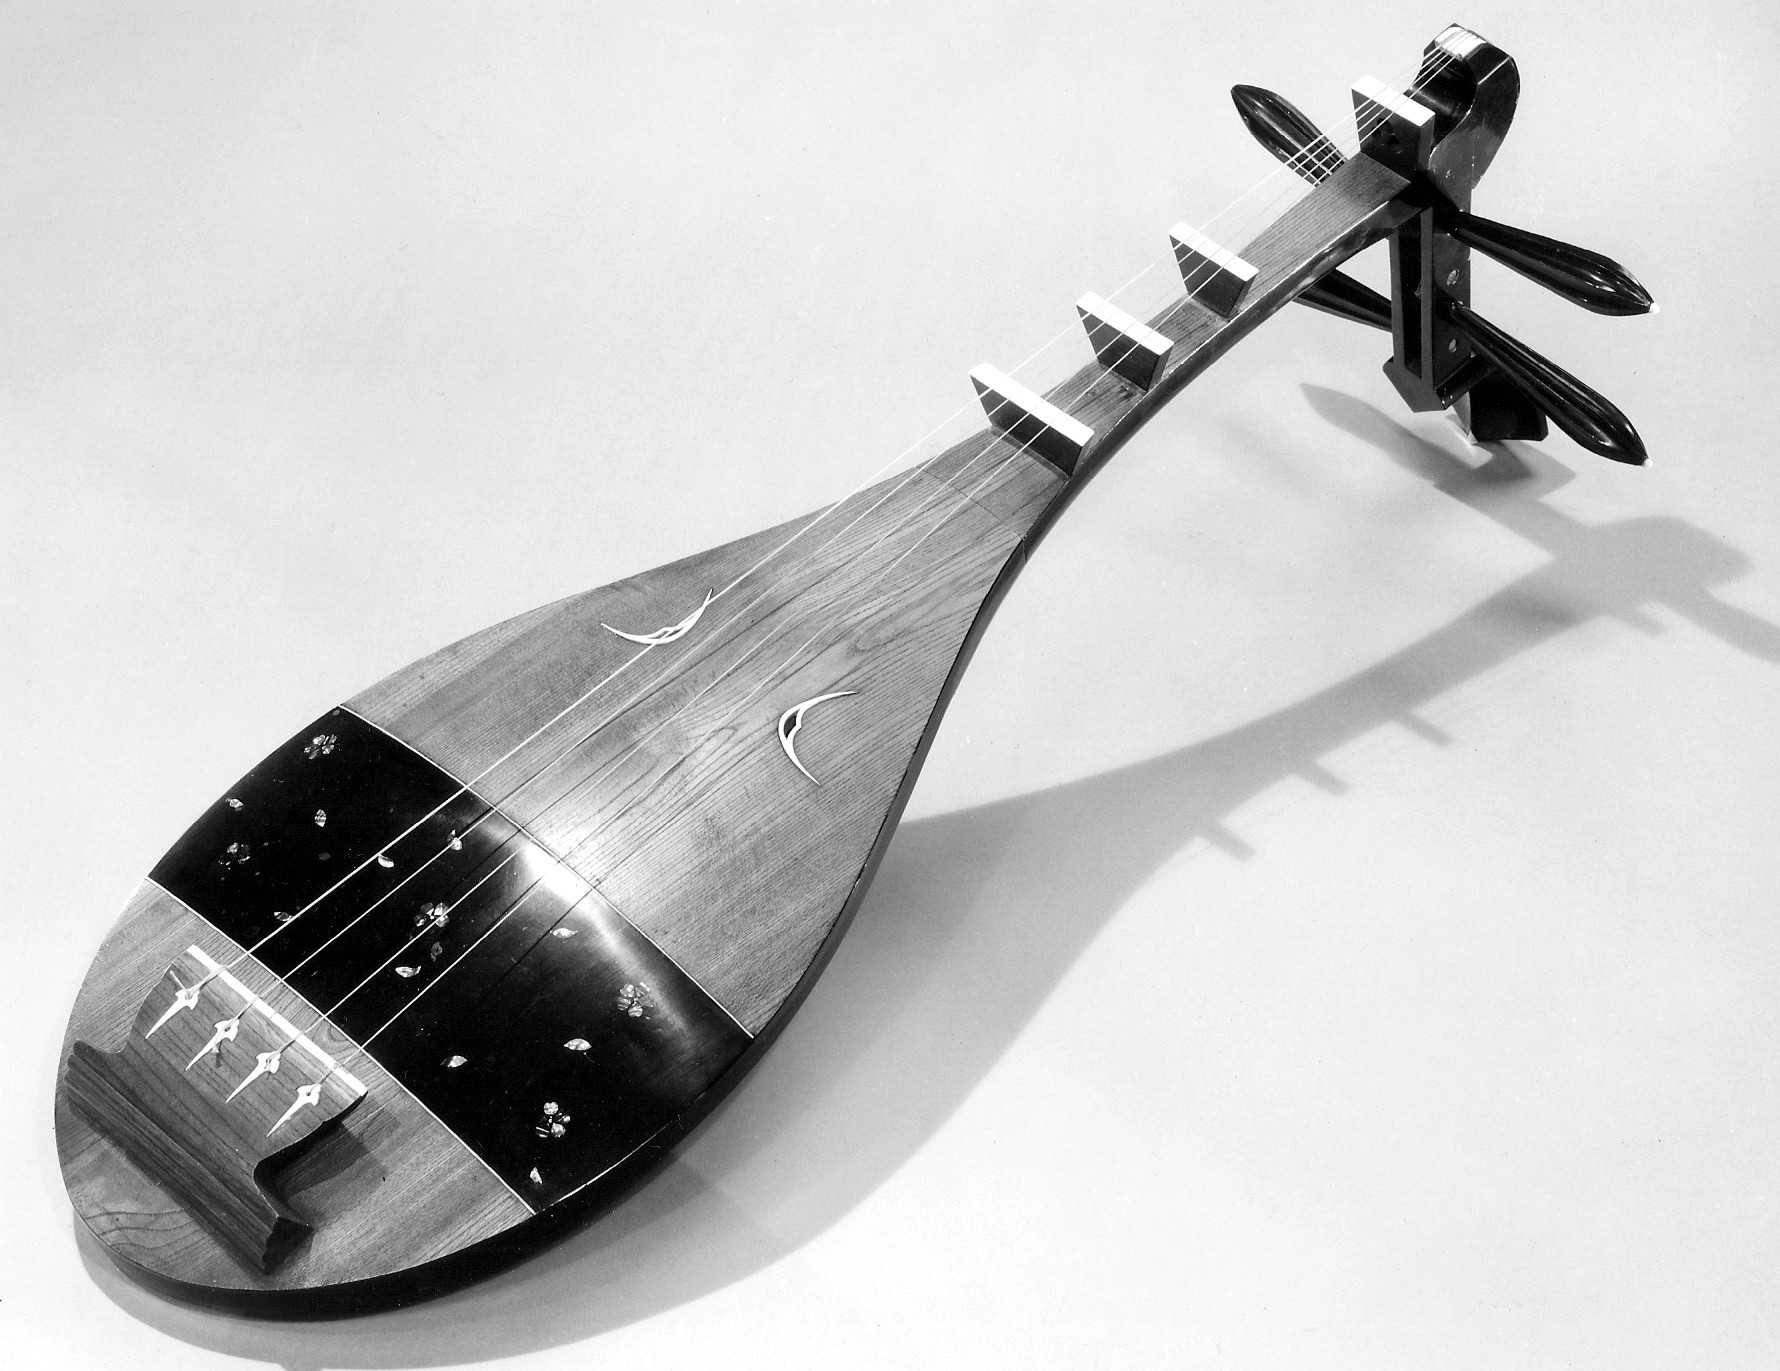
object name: satsuma biwa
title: Satsuma Biwa (薩摩琵琶)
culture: japanese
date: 1800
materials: ivory, mother of pearl, wood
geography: japan